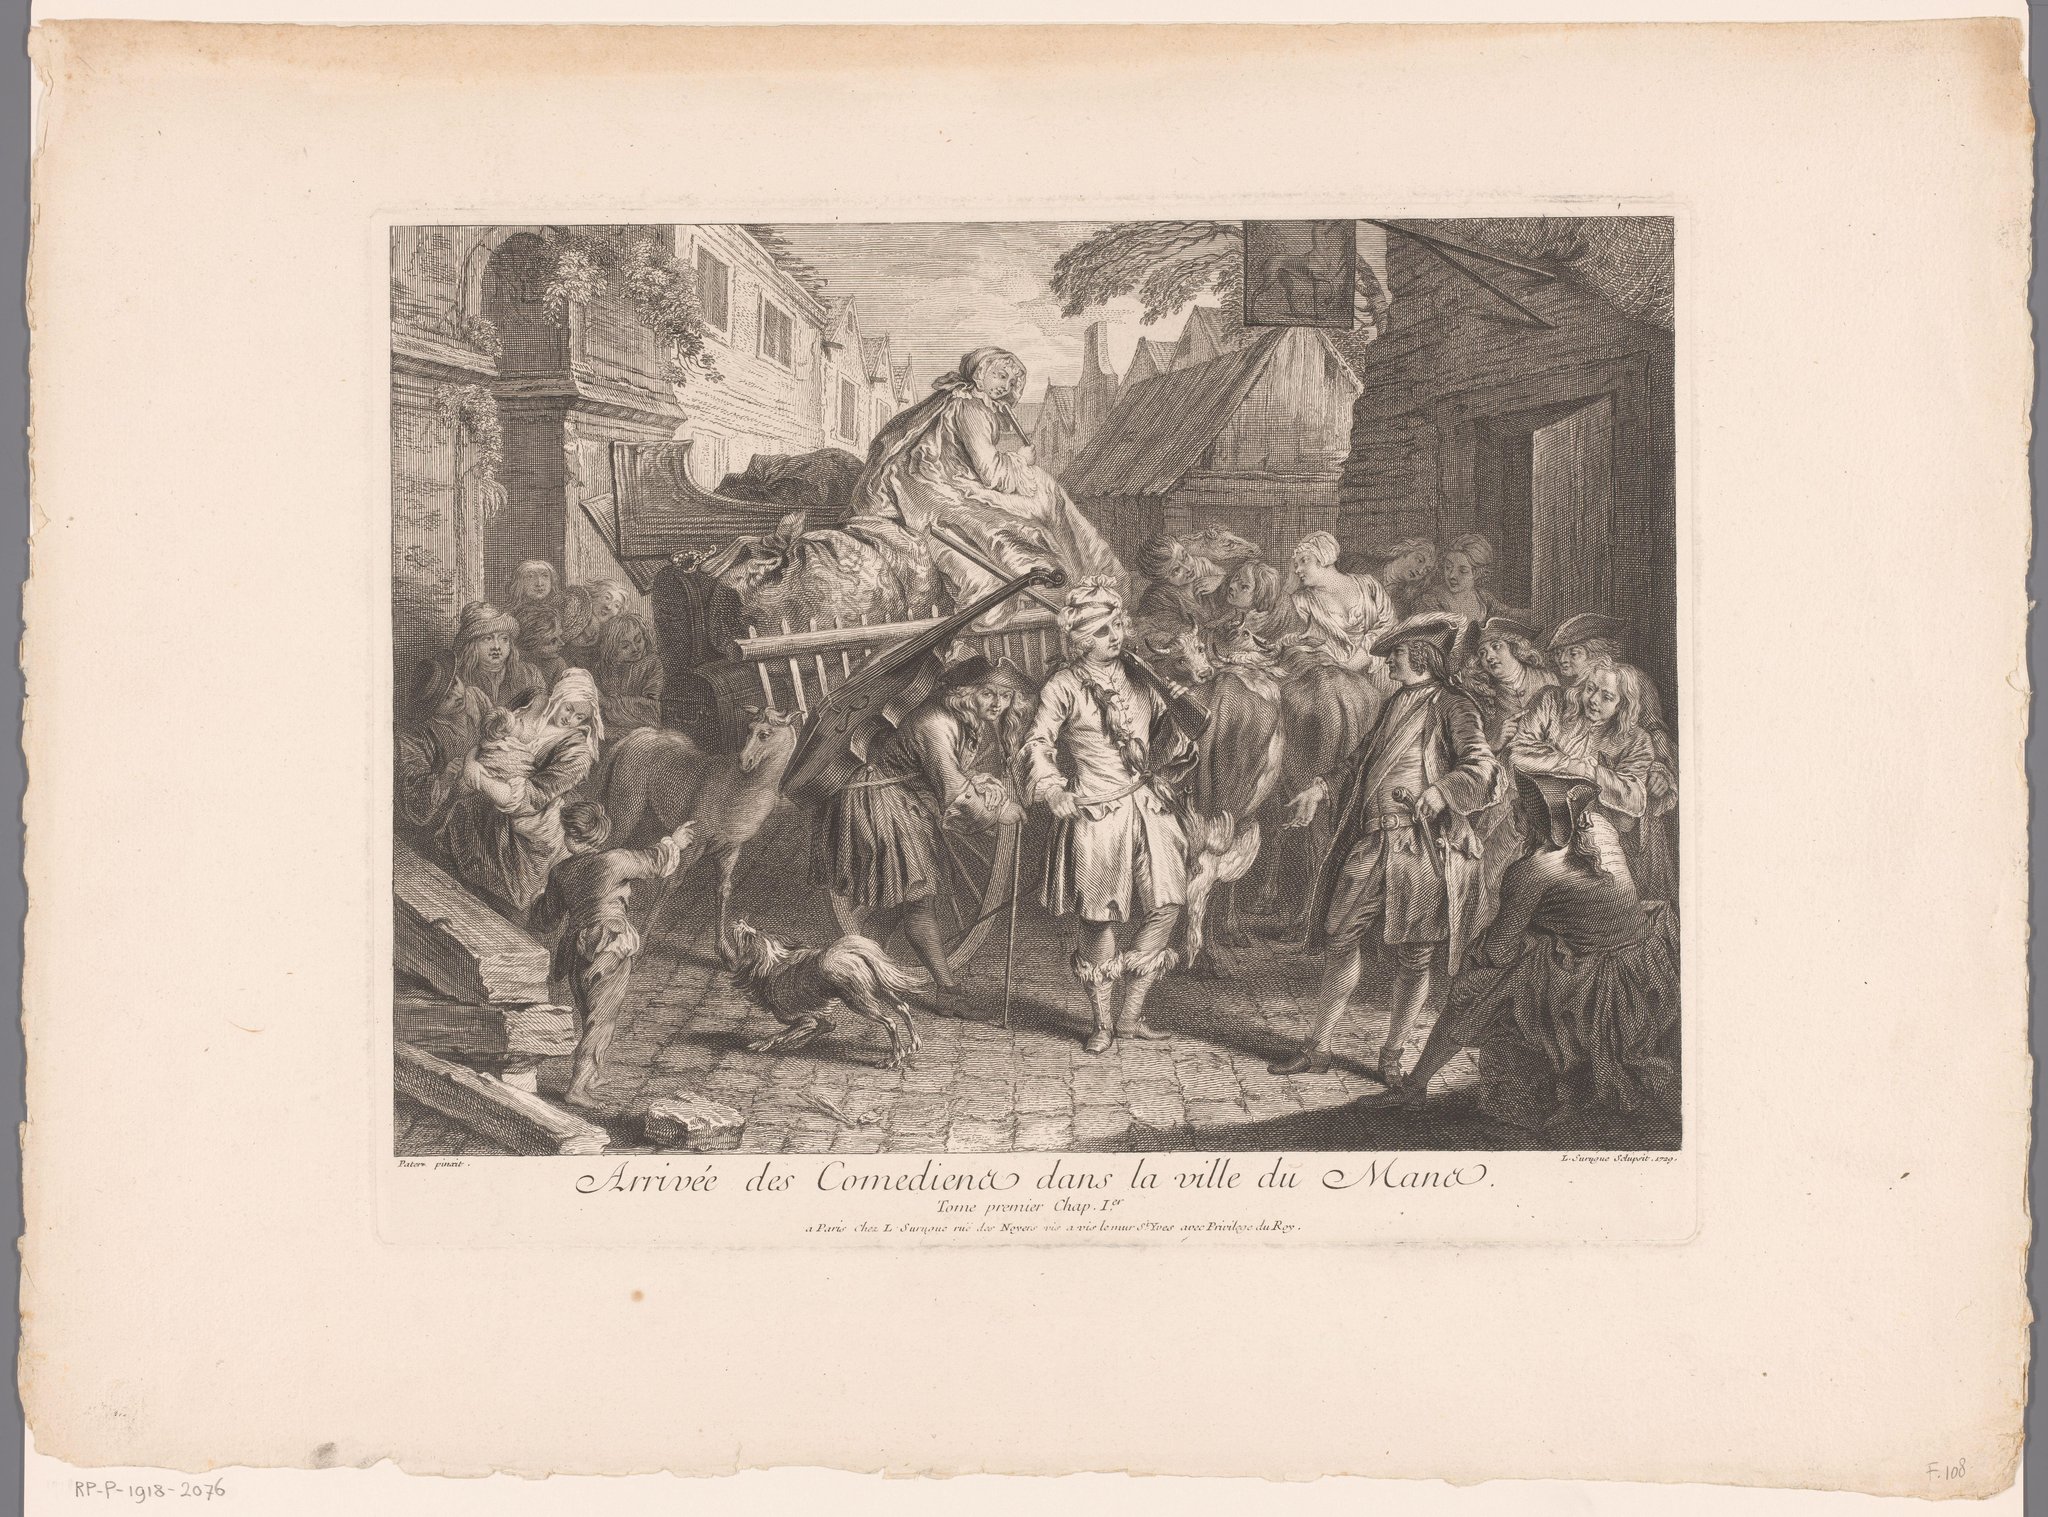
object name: print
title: Scènes uit de Roman Comique van Scarron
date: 1729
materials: paper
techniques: engraving, etching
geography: france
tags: (scarron, roman comique) specific works of literature (with author, title), troupe entering town, announcing the performance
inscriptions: collector's mark: Lugt 2233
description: Serie van 16 prenten bij de Roman Comique van Scarron, waarvan een aantal door Louis en Pierre Louis Surugue.